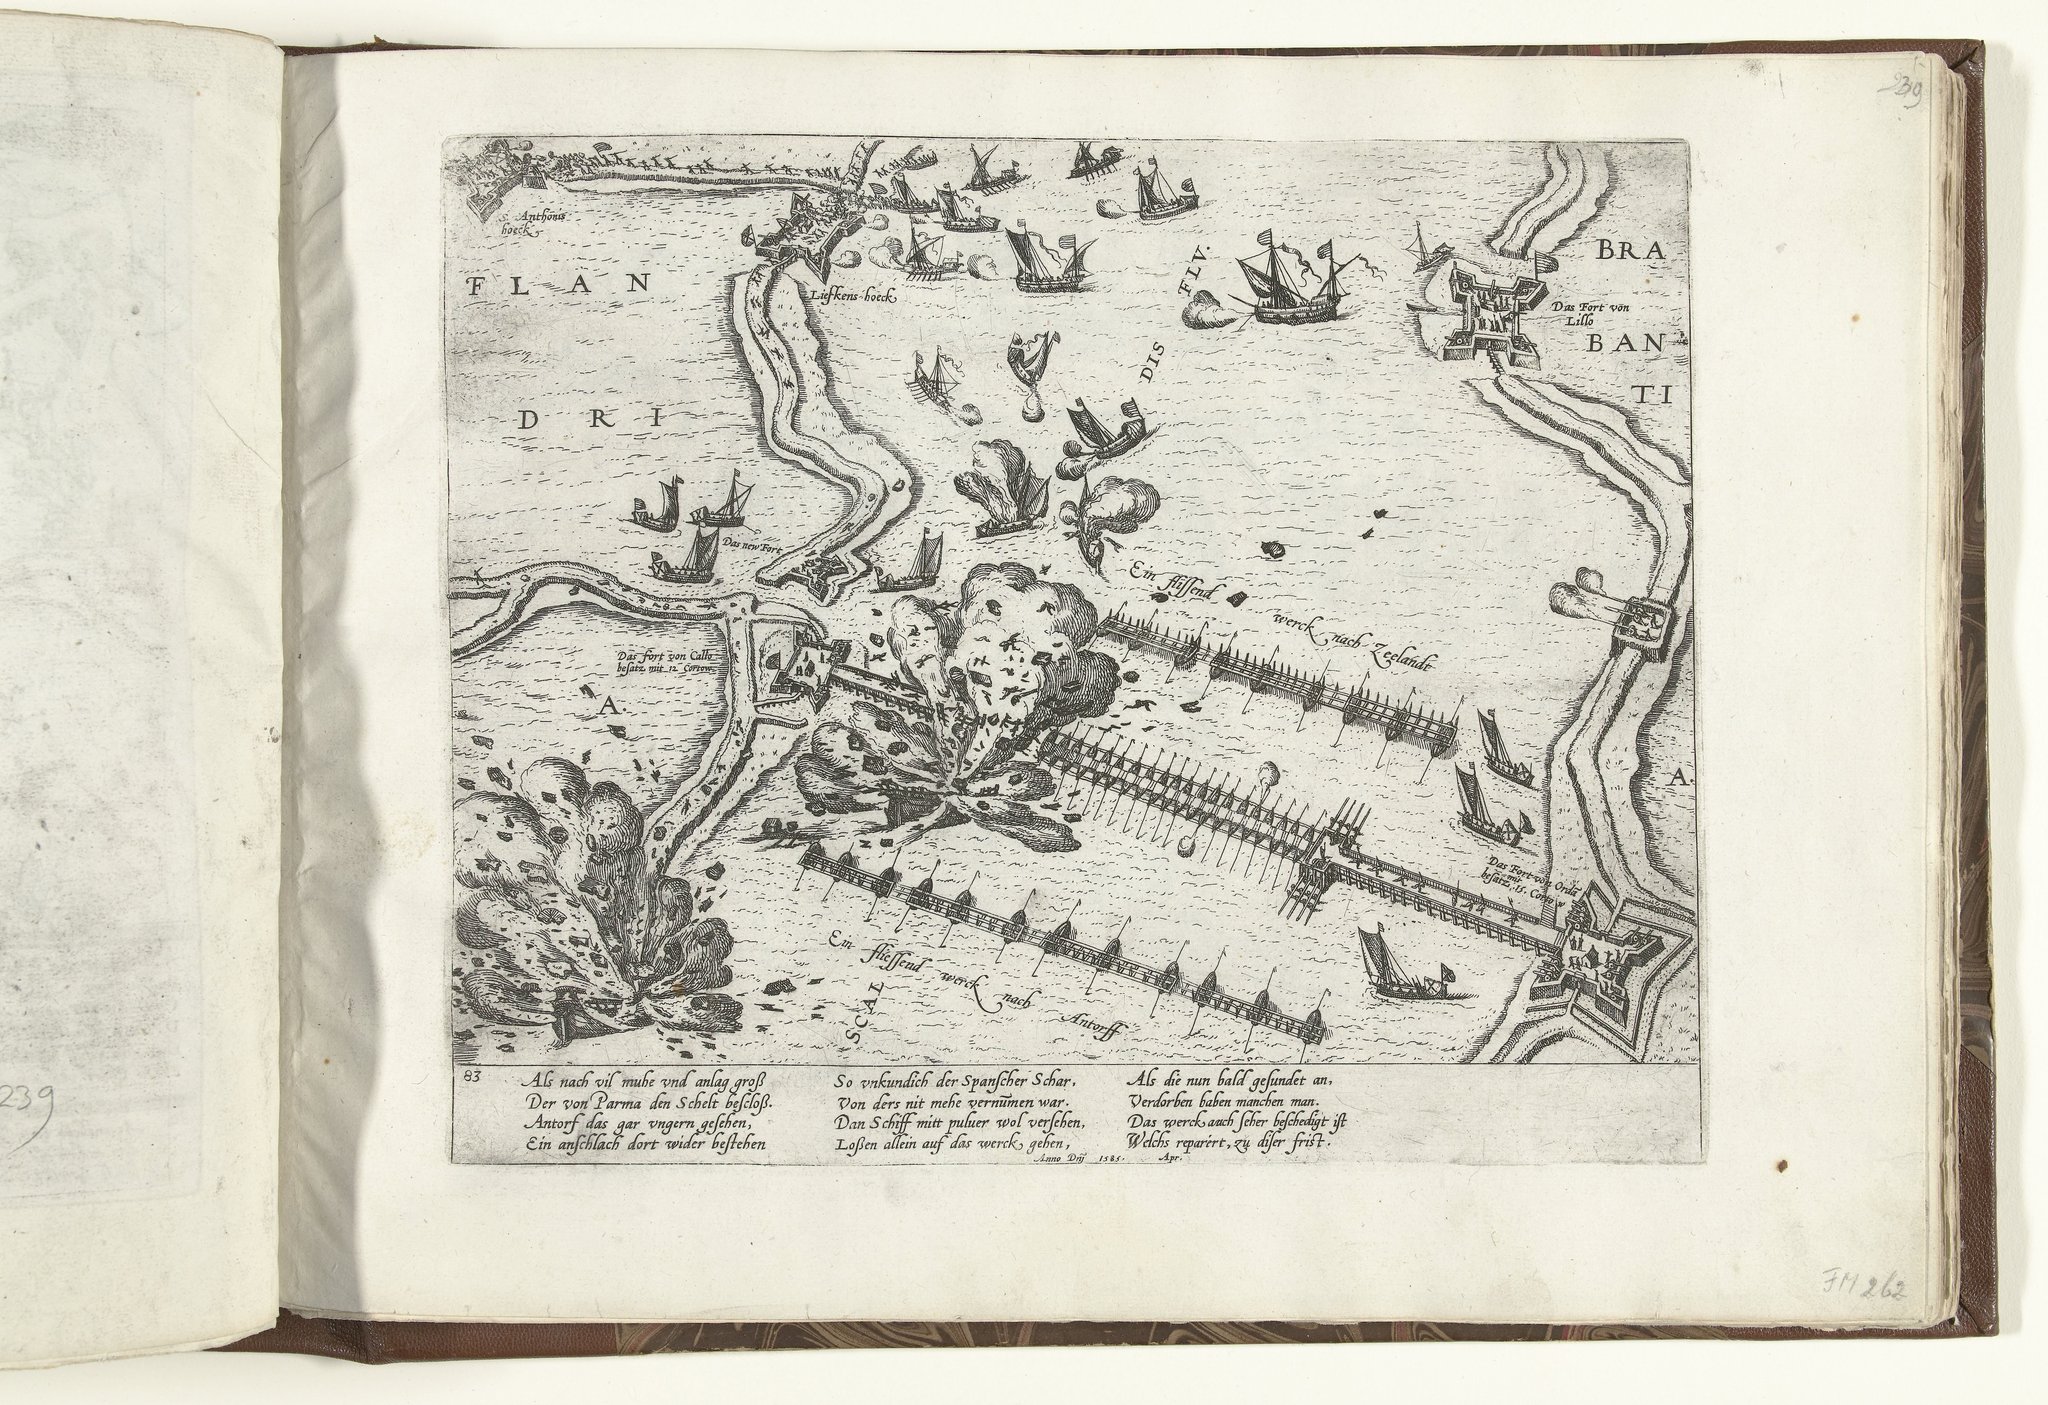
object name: print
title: Schipbrug van Parma over de Schelde opgeblazen, 1585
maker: frans hogenberg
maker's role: print maker, publisher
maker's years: 1538-1590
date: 1585-1587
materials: paper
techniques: etching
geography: cologne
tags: alessandro farnese (landvoogd van de nederlanden en hertog van parma en piacenza), pontoon bridge, antwerp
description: Schipbrug van de hertog van Parma over de Schelde opgeblazen, 5 april 1585. Met onderschrift van 12 regels in het Duits. Genummerd: 83.